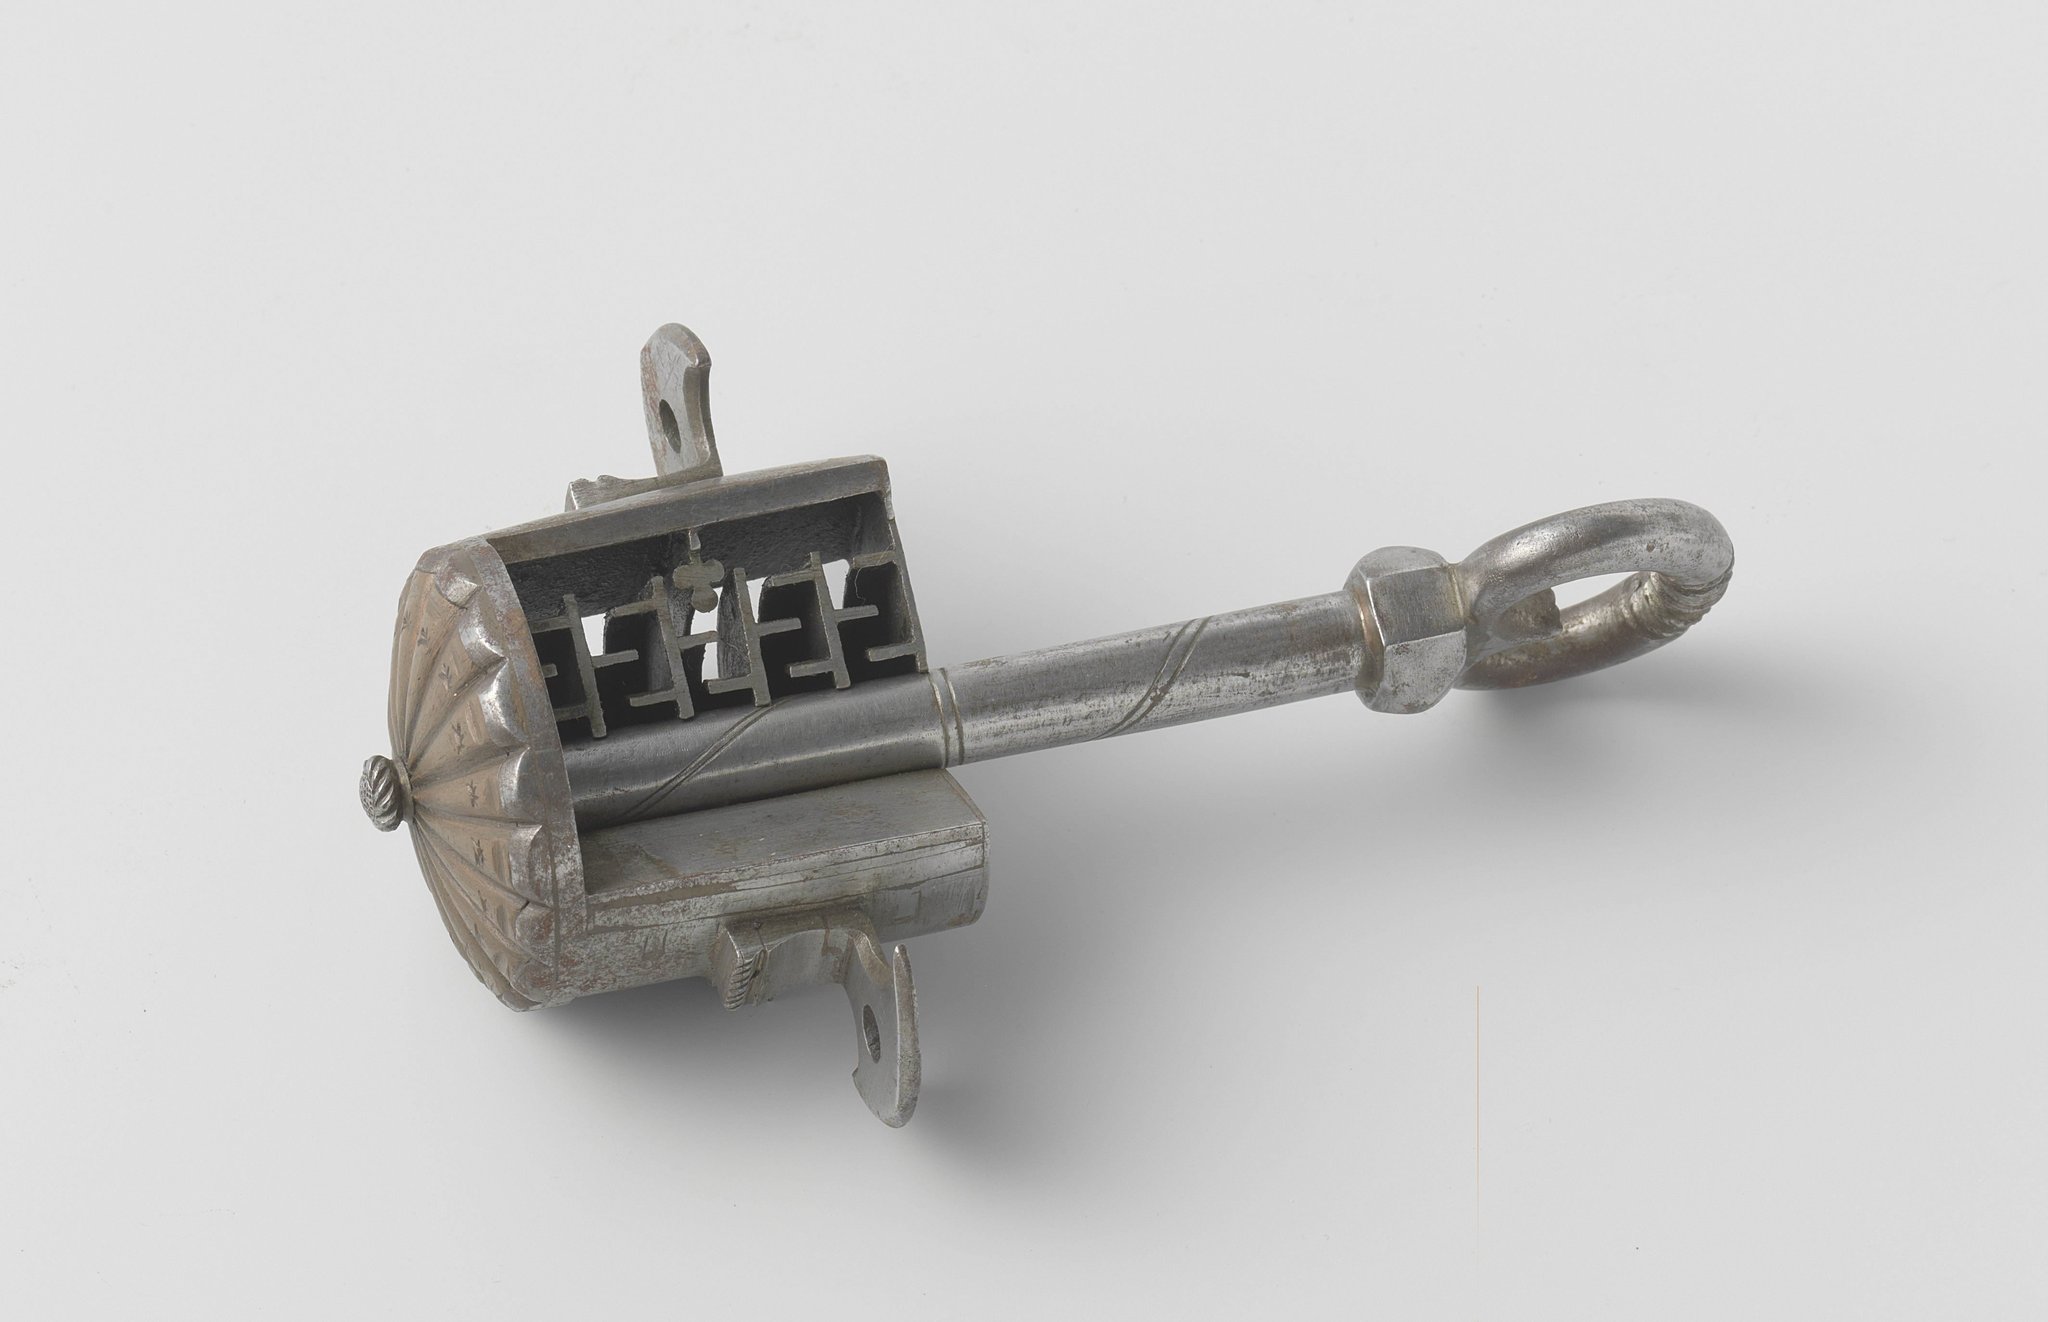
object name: key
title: Slot van ijzer met sleutel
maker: Anonymous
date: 1500-1600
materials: iron